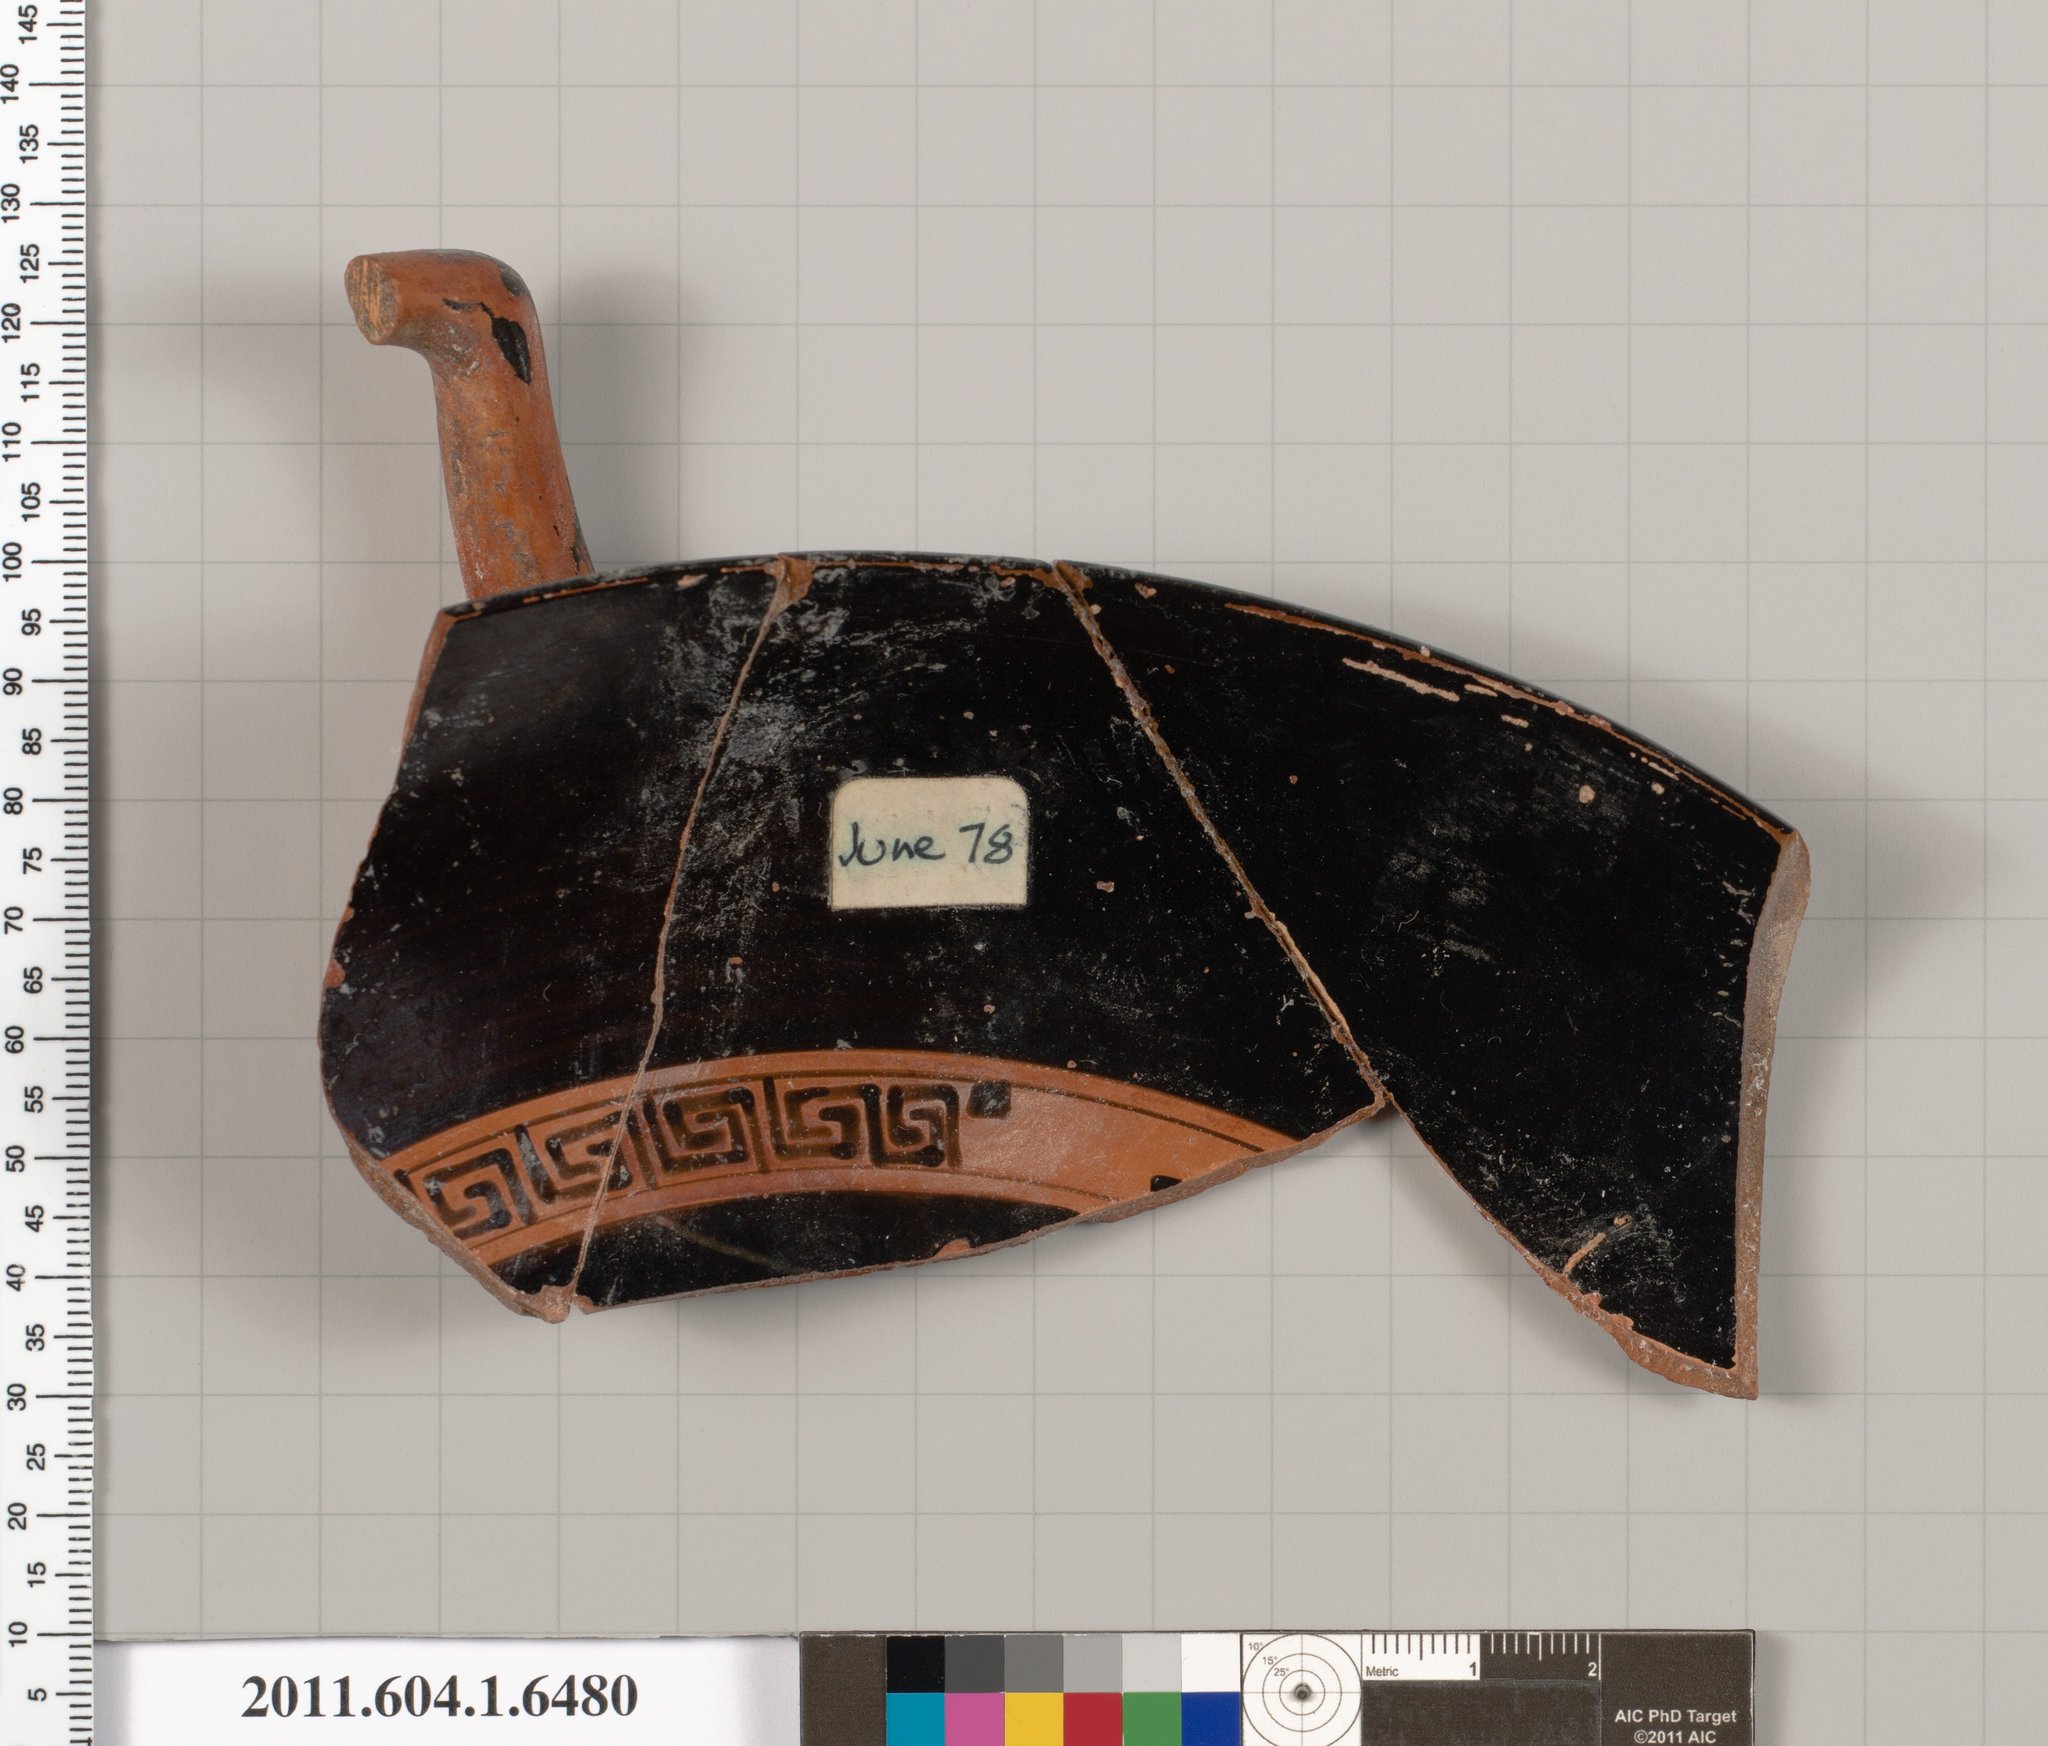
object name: kylix fragment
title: Terracotta fragment of a kylix (drinking cup)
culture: greek, attic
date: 490-480 BCE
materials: terracotta